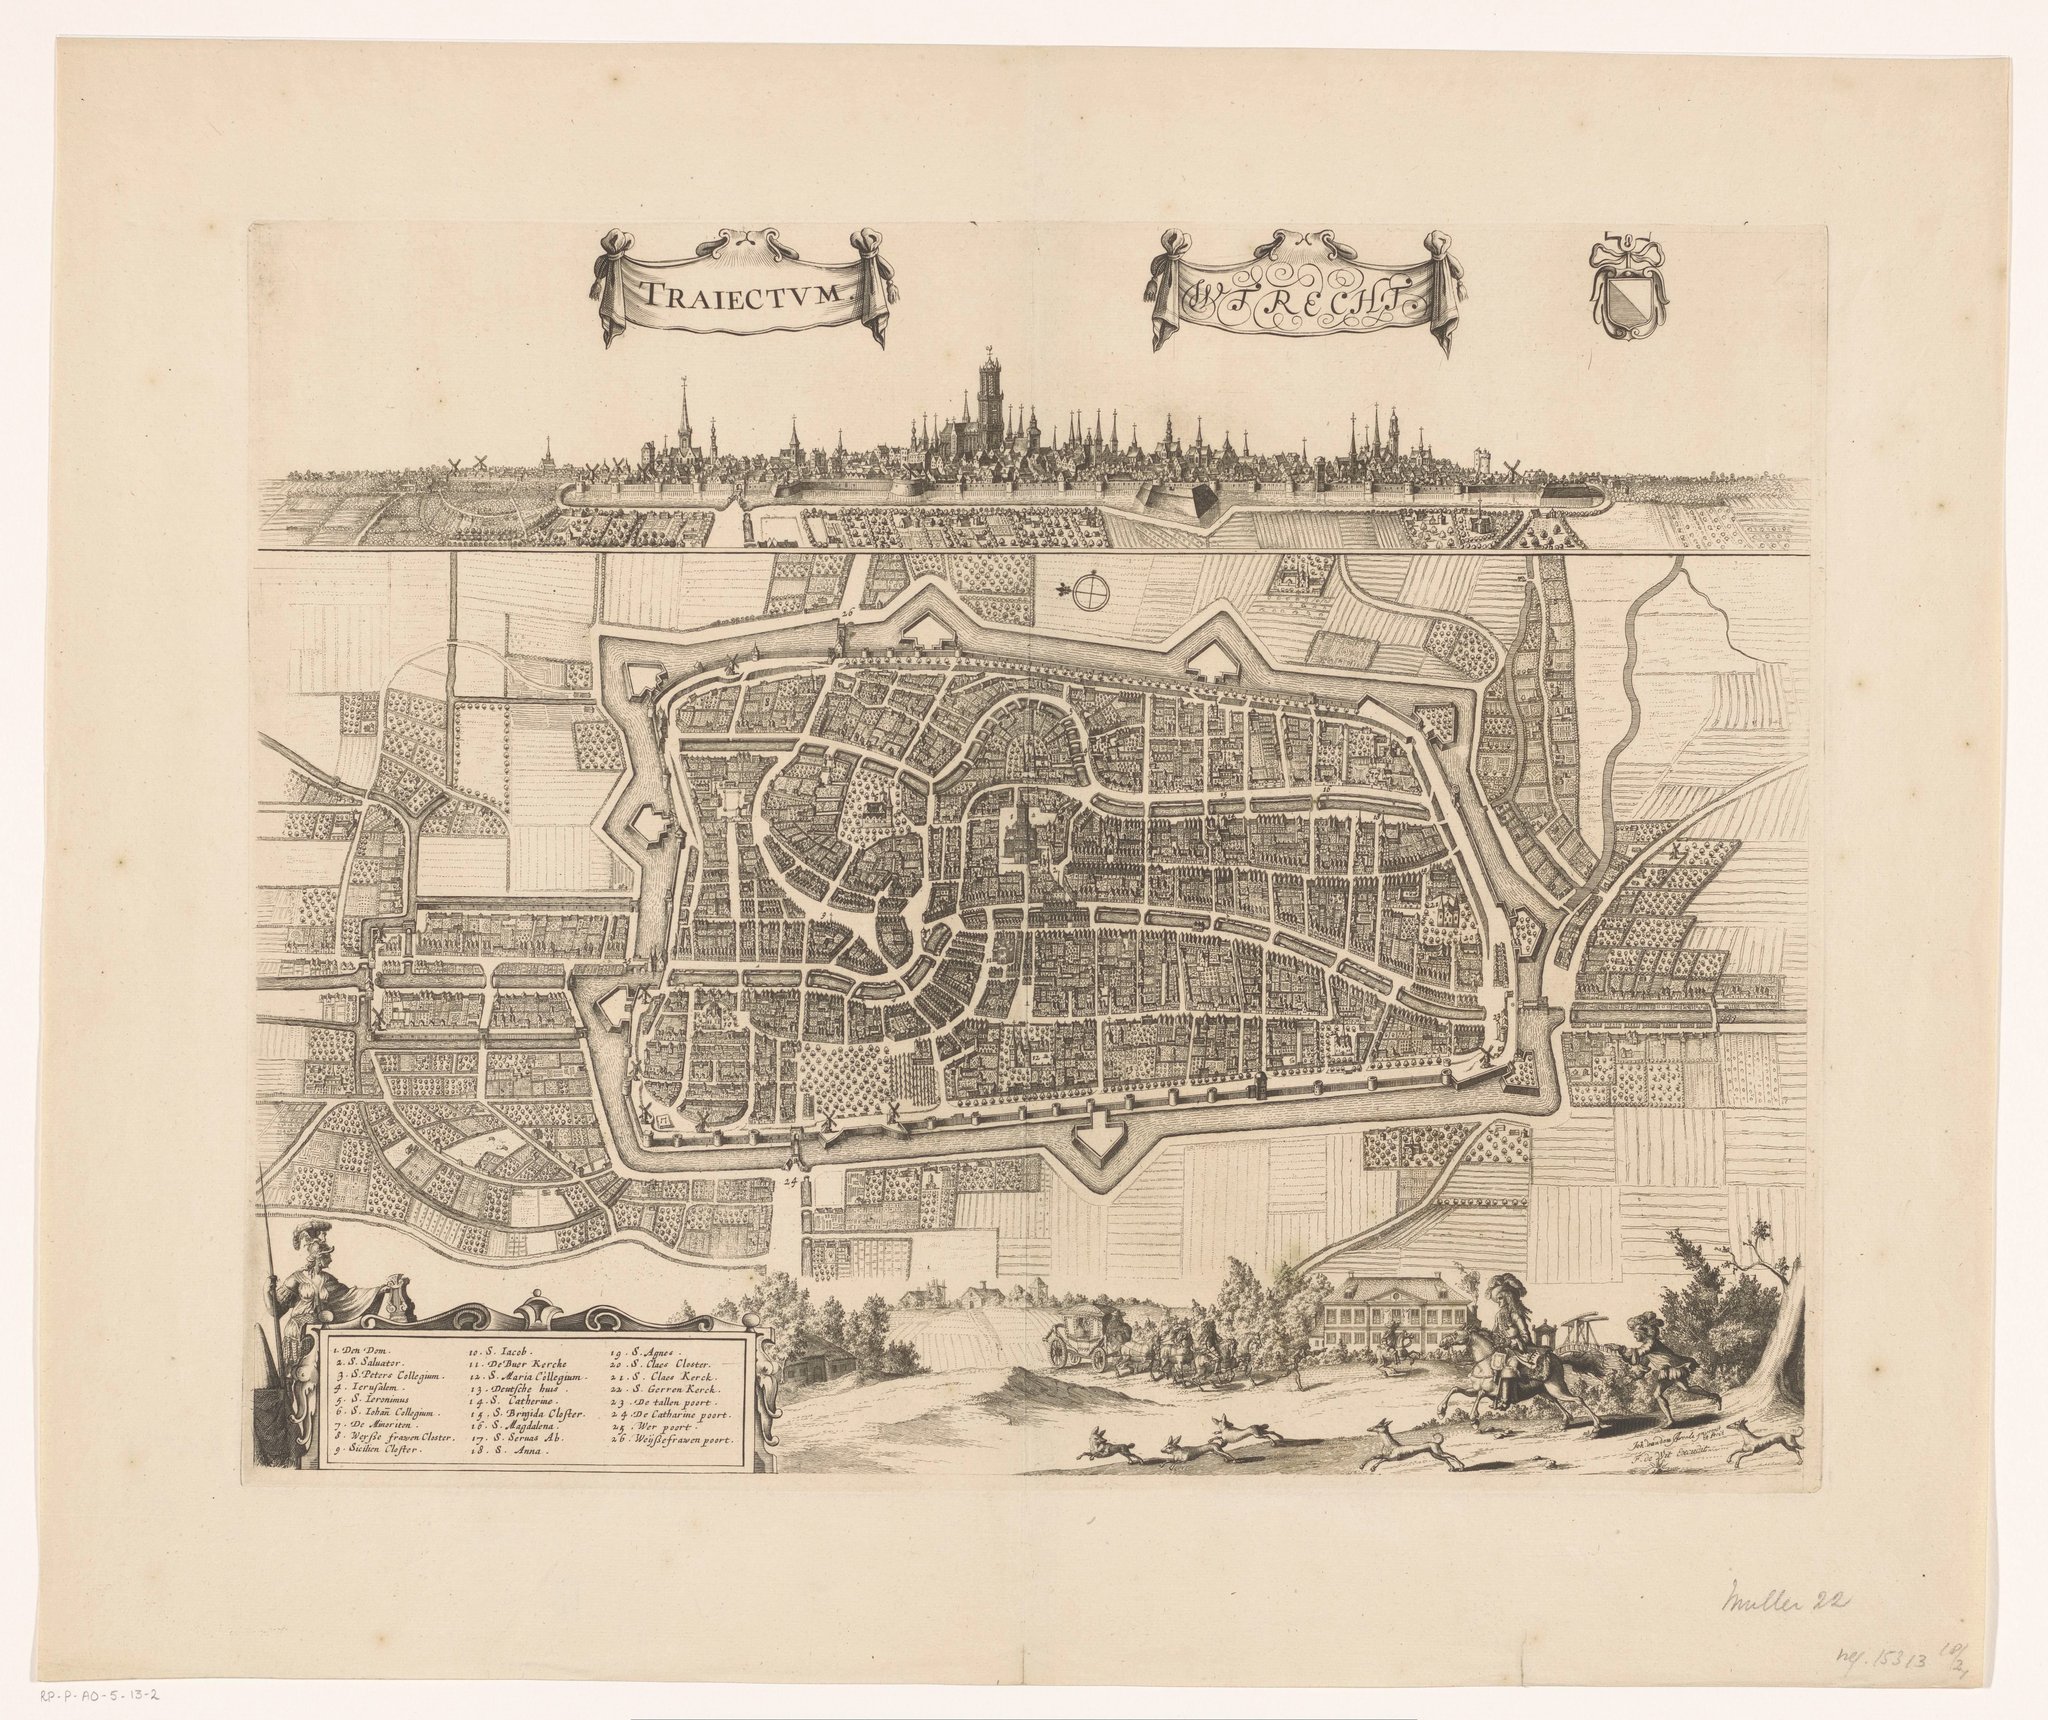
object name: area plan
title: Plattegrond van de stad Utrecht met stadsgezicht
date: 1657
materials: paper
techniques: engraving, etching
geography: amsterdam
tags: riding a horse, ass, or mule; rider, horseman, coat of arms (as symbol of the state, etc.), city-view in general; 'veduta', (story of) minerva (pallas, athena), hunting dogs, maps of cities, passenger carriage, country-house, utrecht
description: Boven een stadsgezicht met daarop rechtsboven het wapen van de stad Utrecht. Daaronder een plattegrond in vogelvluchtperspectief. Linksonder een cartouche met de legenda, links daarvan Minerva. Verder een aantal figuren, een buitenhuis, een koets met paarden, ruiters en jachthonden.